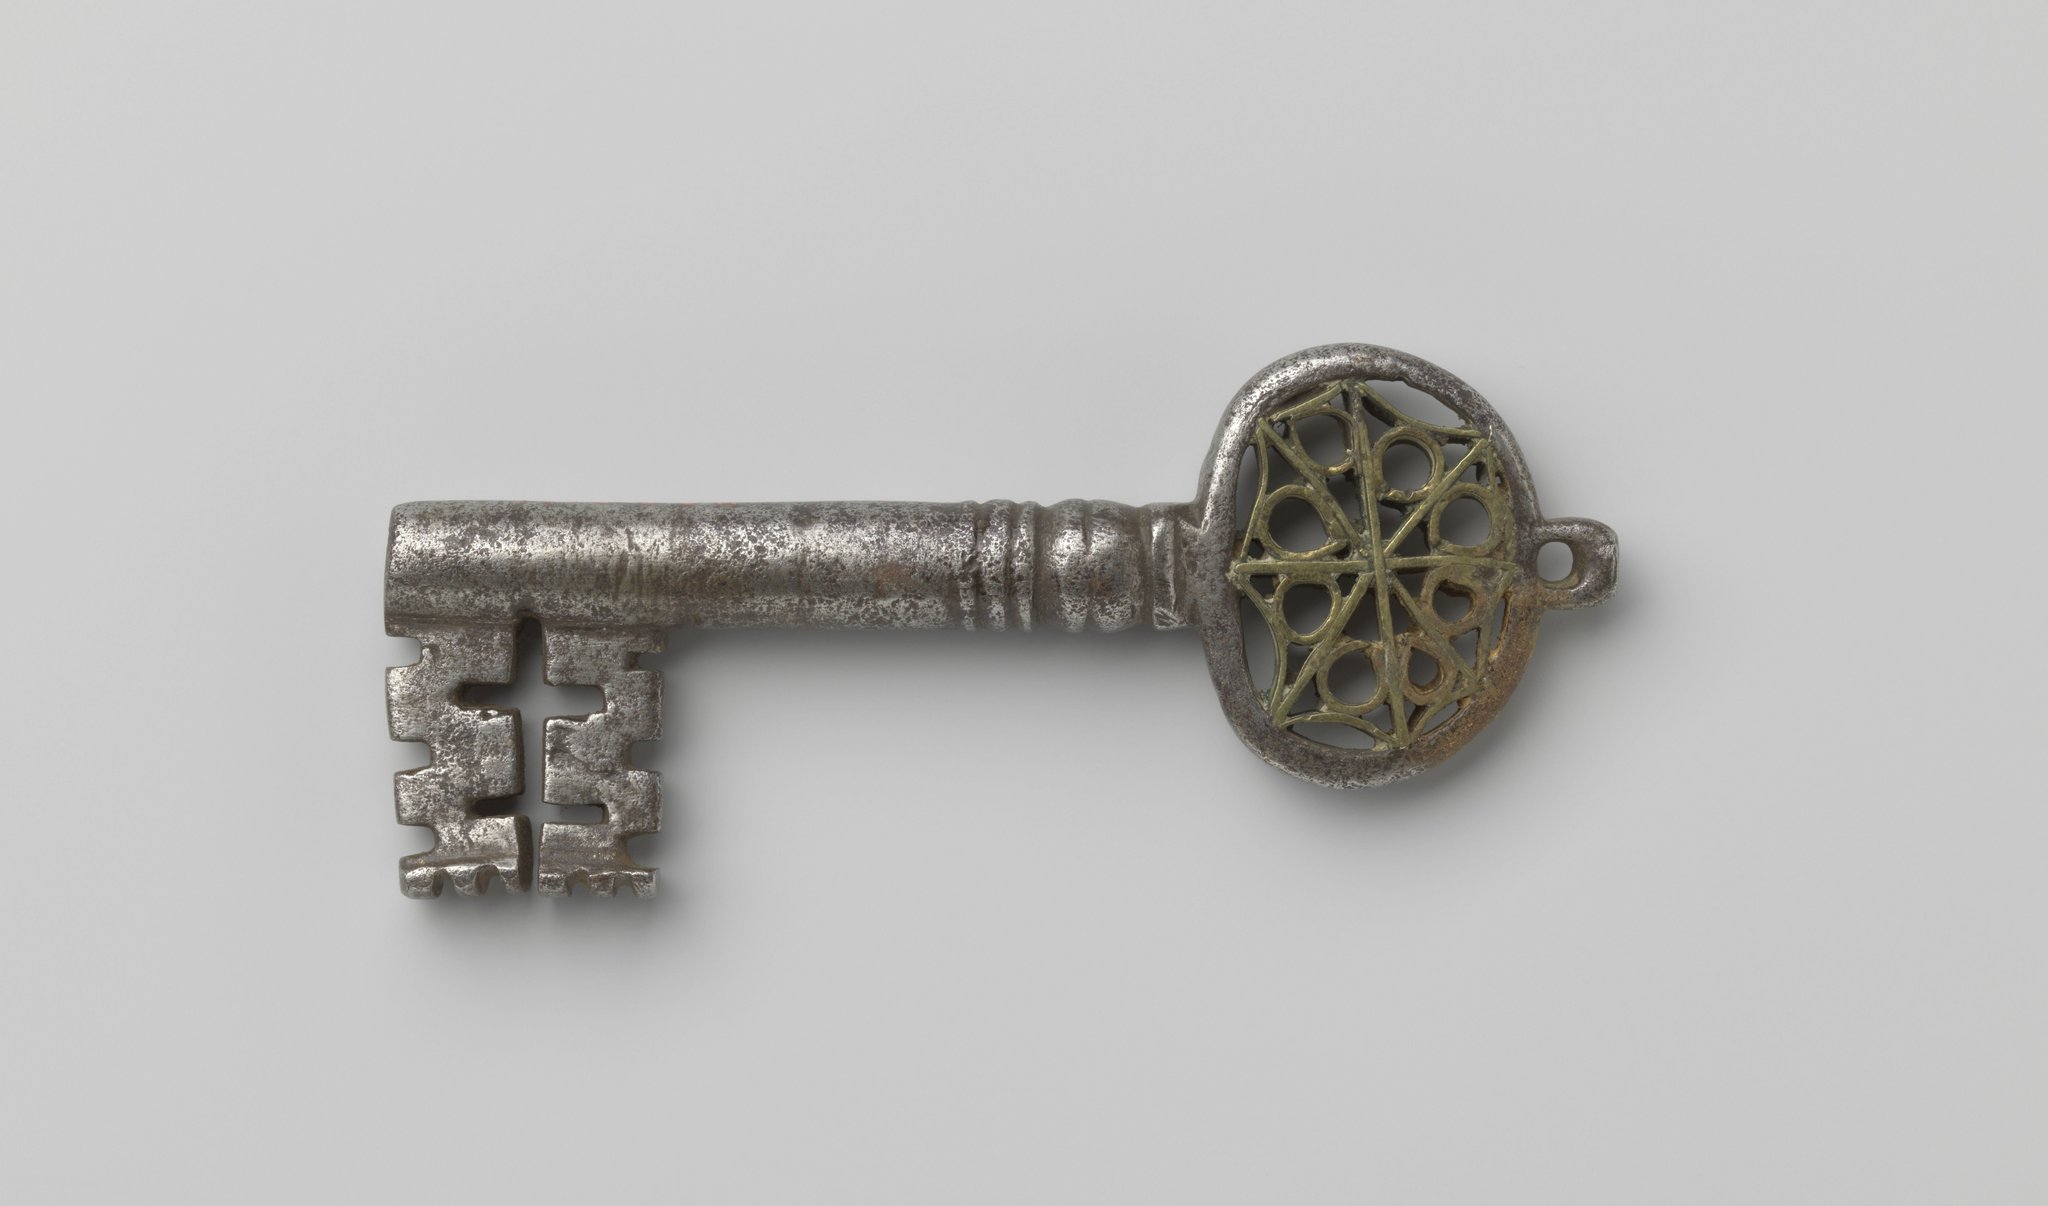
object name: pipe key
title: Pijpsleutel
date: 1400-1950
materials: iron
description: Pijpsleutel "Venetiaansch model" met koperen roos in de greep bekroond door een oogje. De zware schacht is bovenaan geprofileerd.